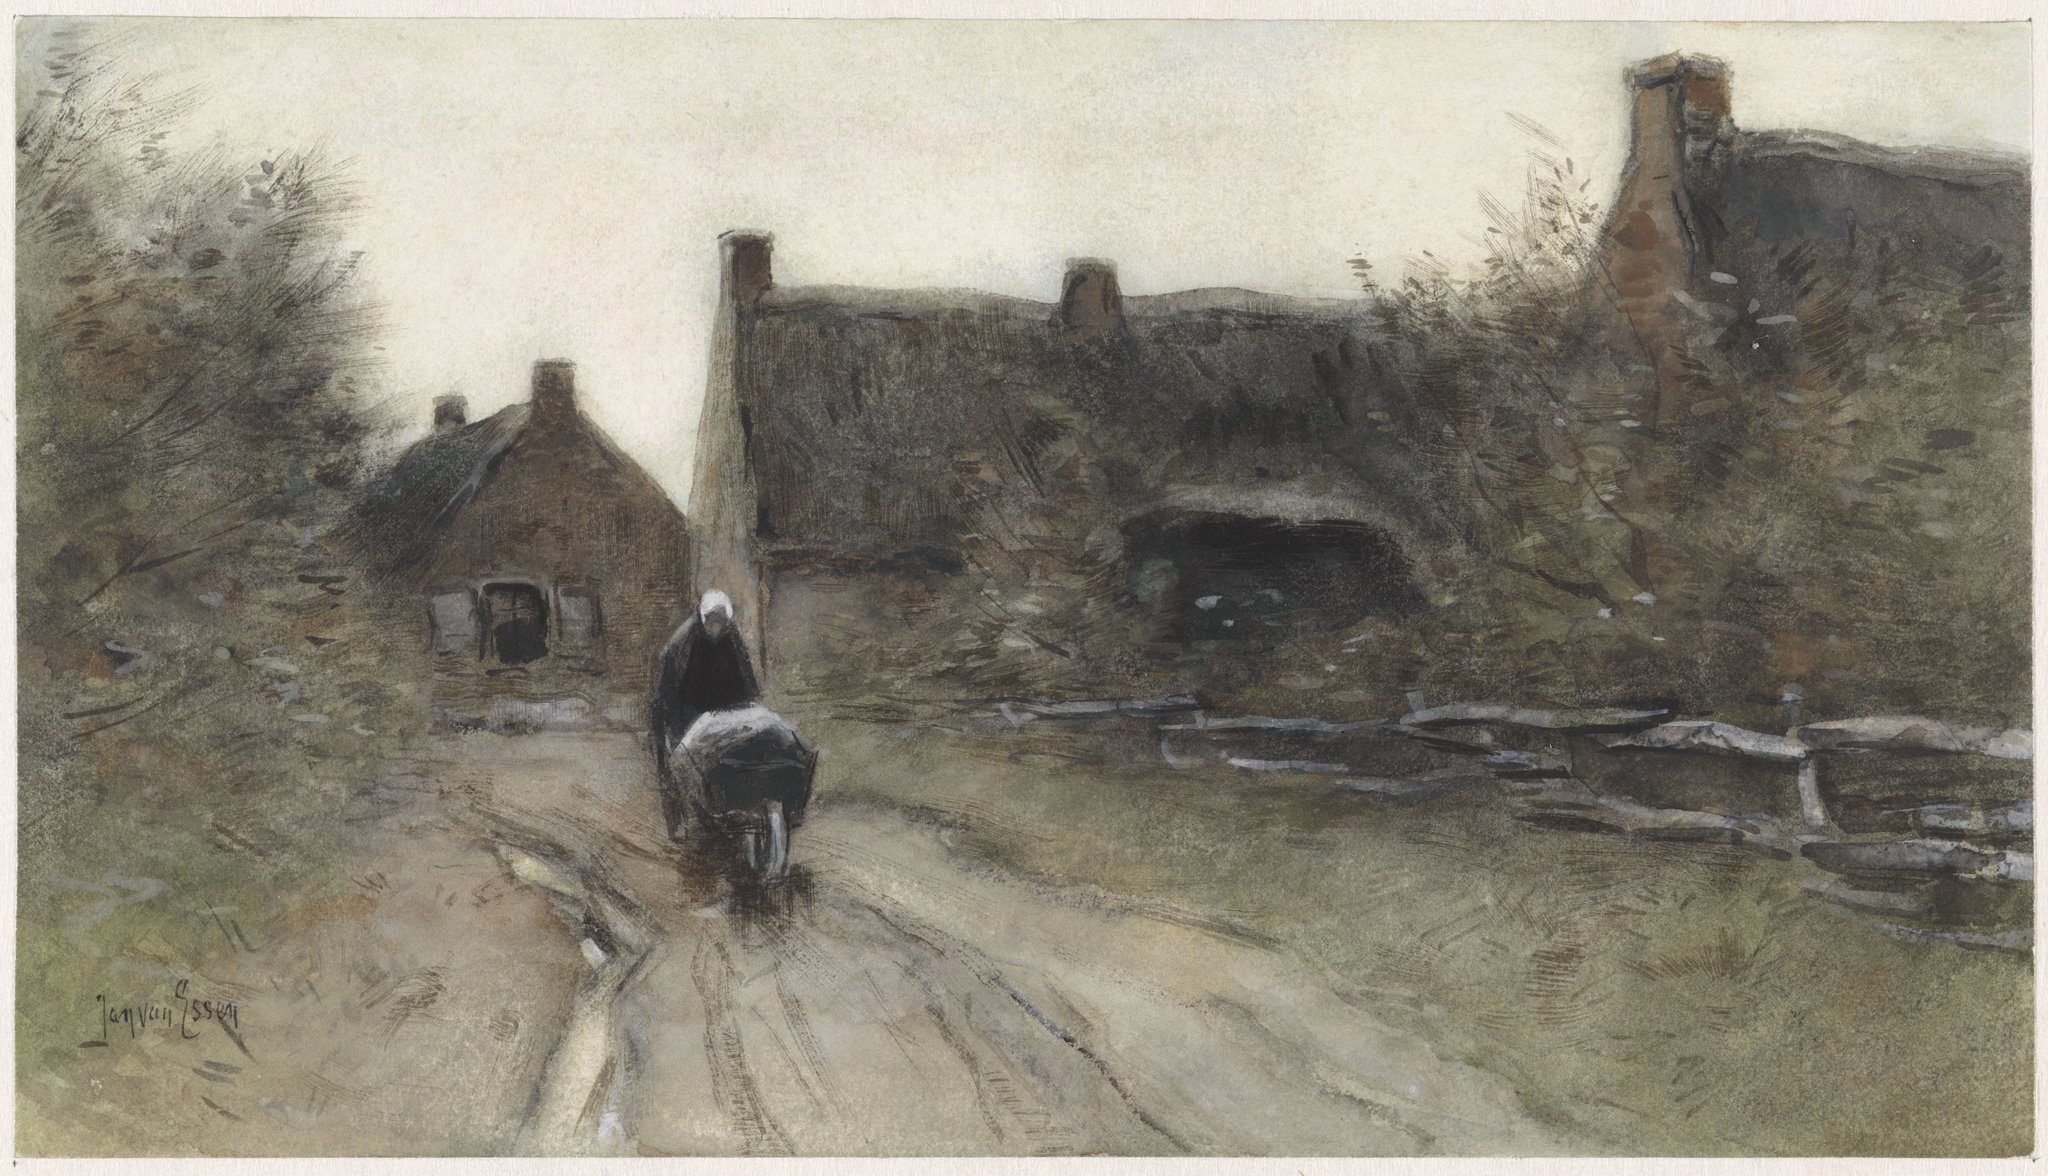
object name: drawing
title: Dorpsgezicht met vrouw met kruiwagen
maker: jan van essen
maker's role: draughtsman, print maker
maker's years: 1854-1936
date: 1864-1892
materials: chalk, paper, watercolor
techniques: brush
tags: village street